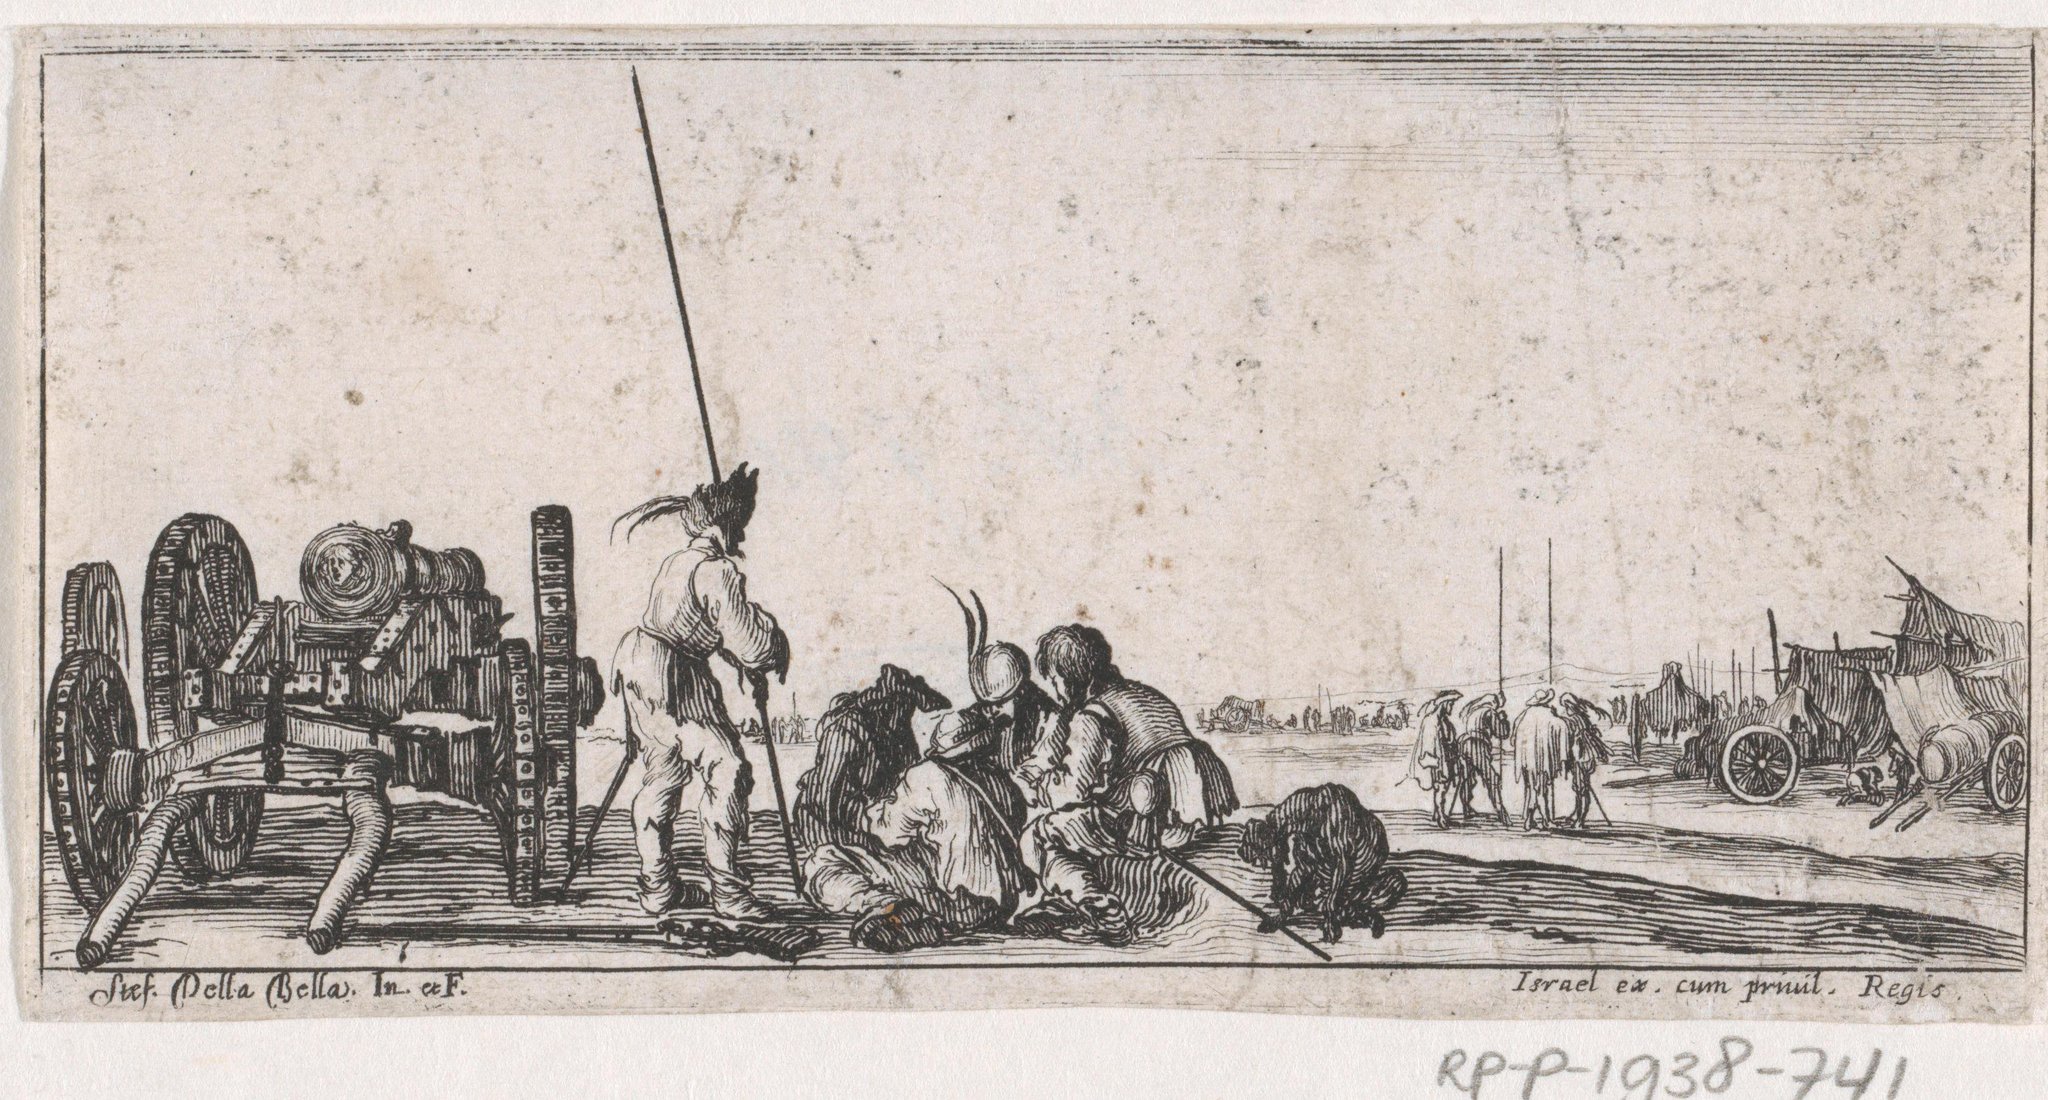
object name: print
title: Desseins de quelques conduites de troupes, canons, et ataques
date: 1620-1664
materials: paper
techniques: etching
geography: paris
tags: leave ~ the soldier off duty, firearms: cannon, playing-cards, the soldier; the soldier's life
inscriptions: collector's mark: Lugt 2228